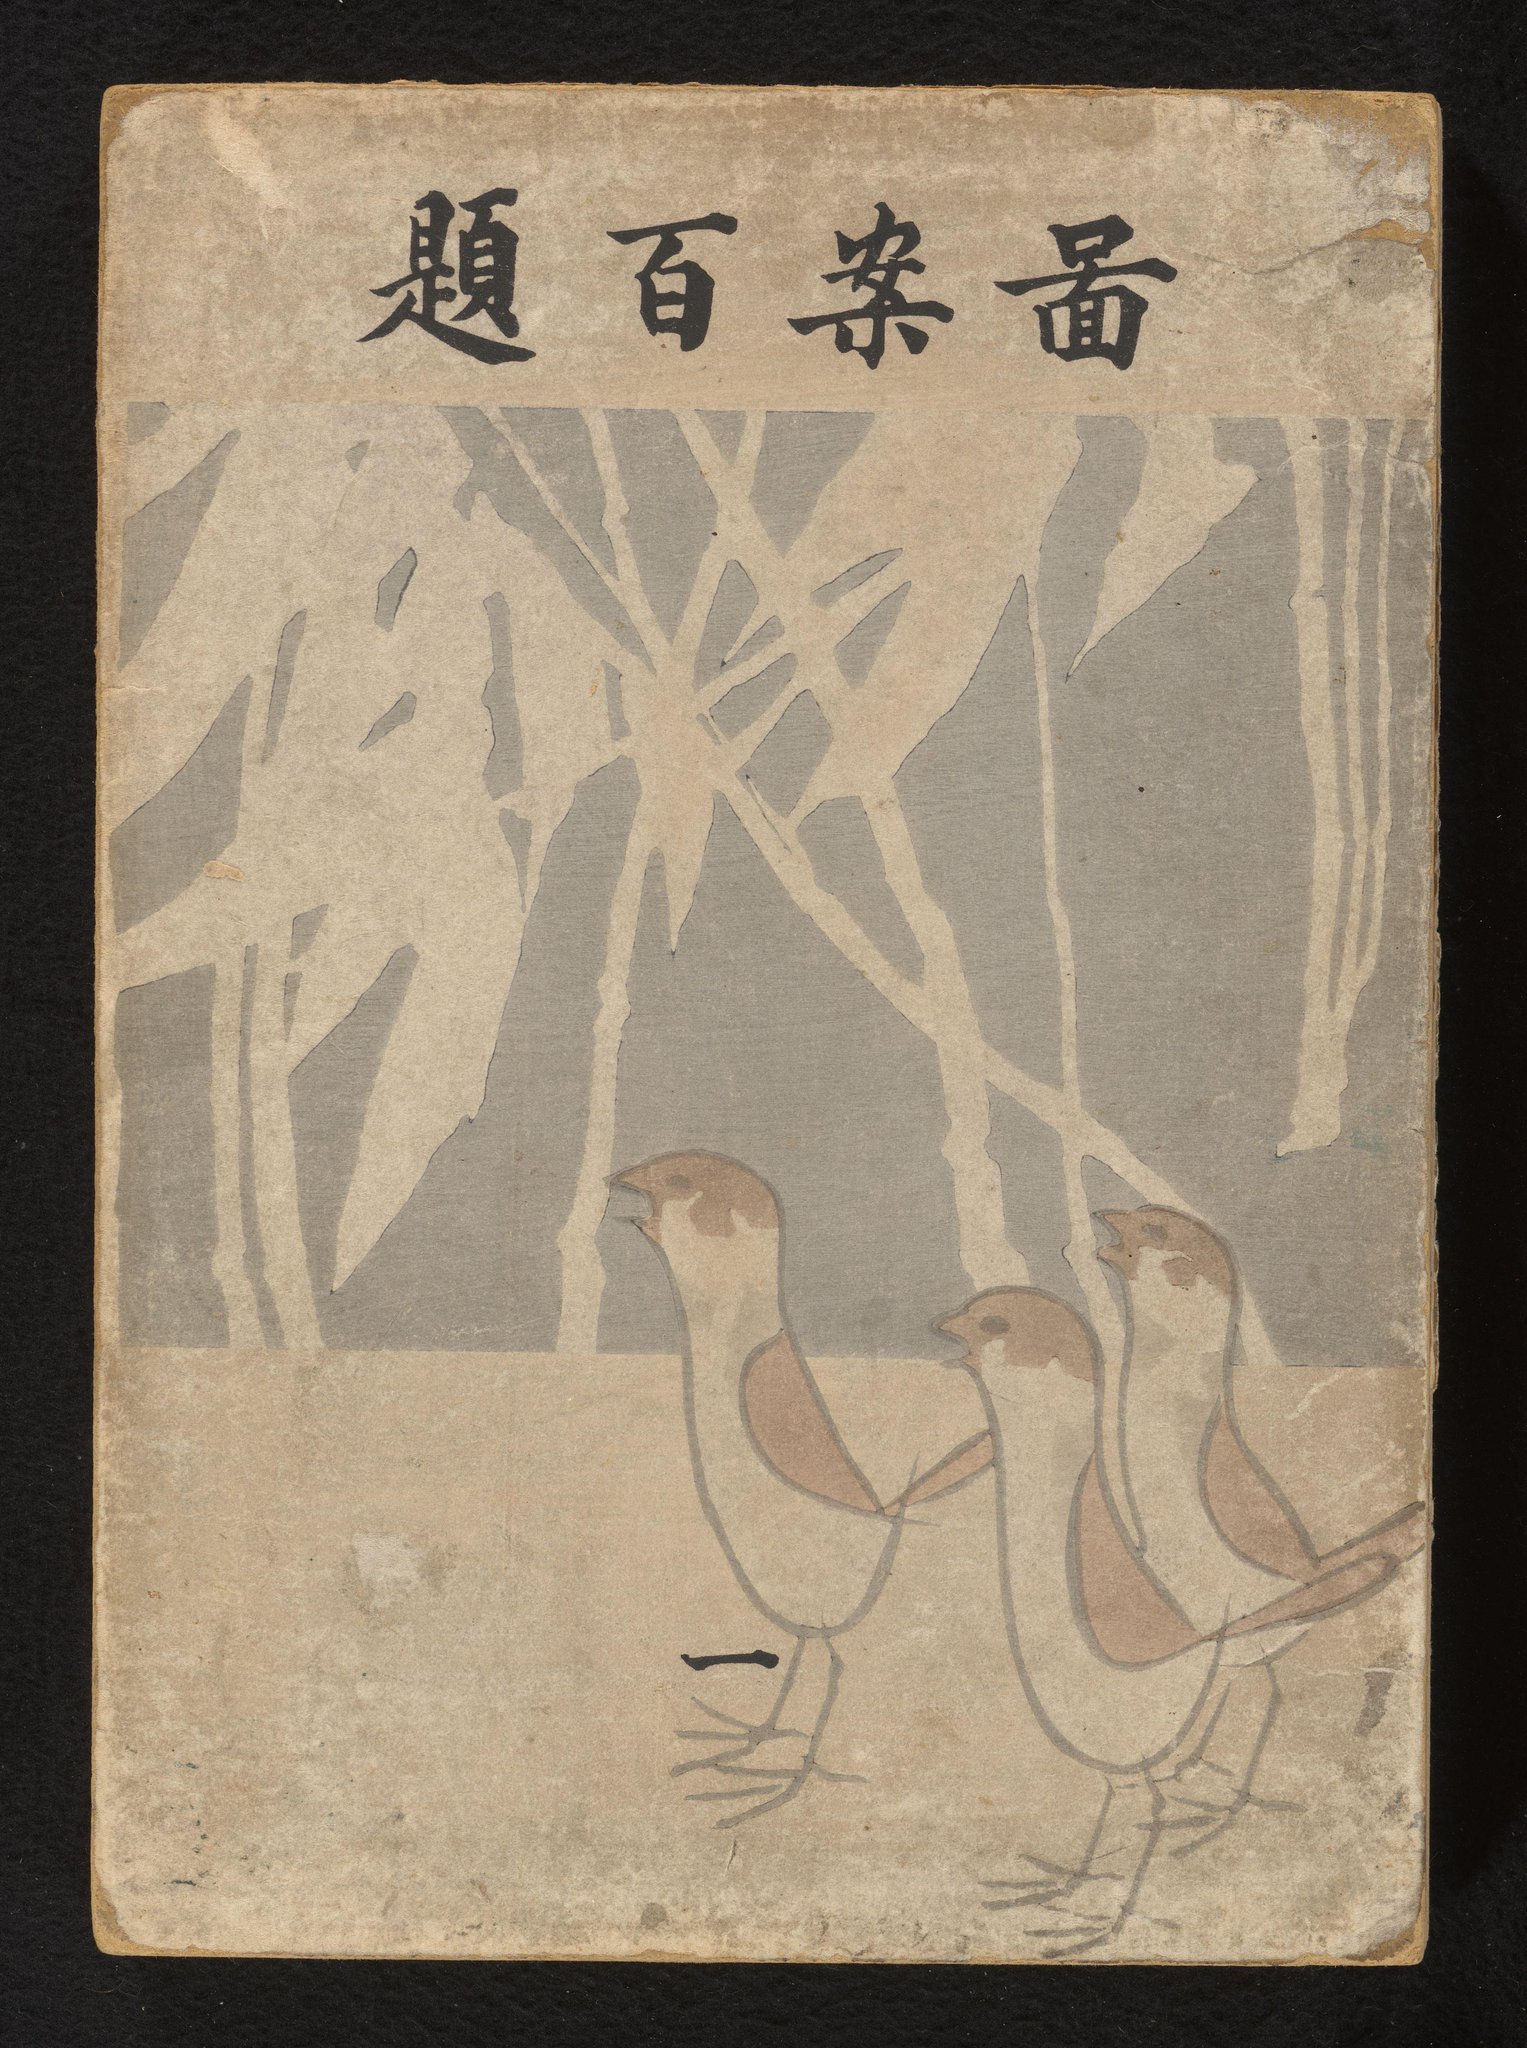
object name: book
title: Honderd ontwerpen - deel één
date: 1910-1911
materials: paper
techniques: woodcut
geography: japan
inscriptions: date